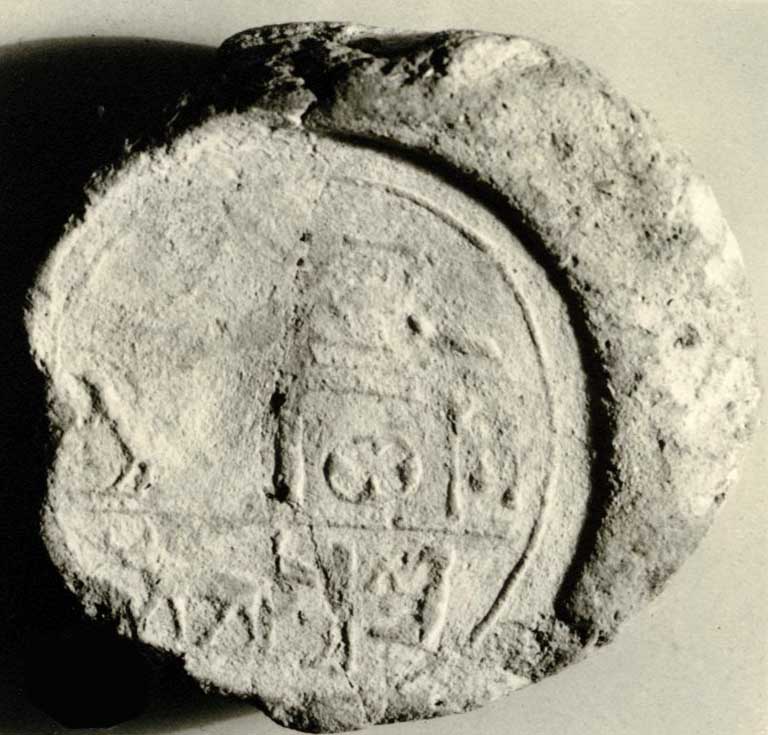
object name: cone of kanakht, scribe, circular impression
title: Funerary Cone of the Scribe Kanakht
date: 1550-1295 BCE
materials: pottery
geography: egypt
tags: hieroglyphs